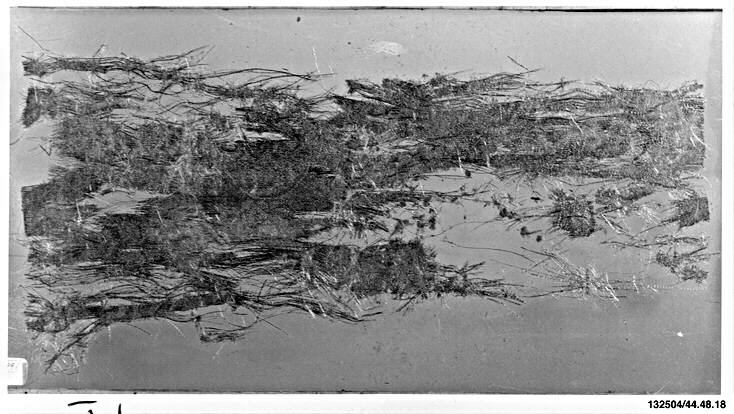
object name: fragment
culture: japanese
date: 701-800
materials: textile